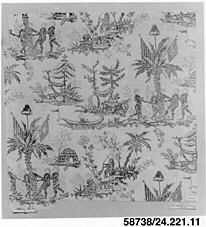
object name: furnishing textile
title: The Dance of the Liberty Tree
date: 1795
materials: cotton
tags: human figures,dance,trees,flags,boats